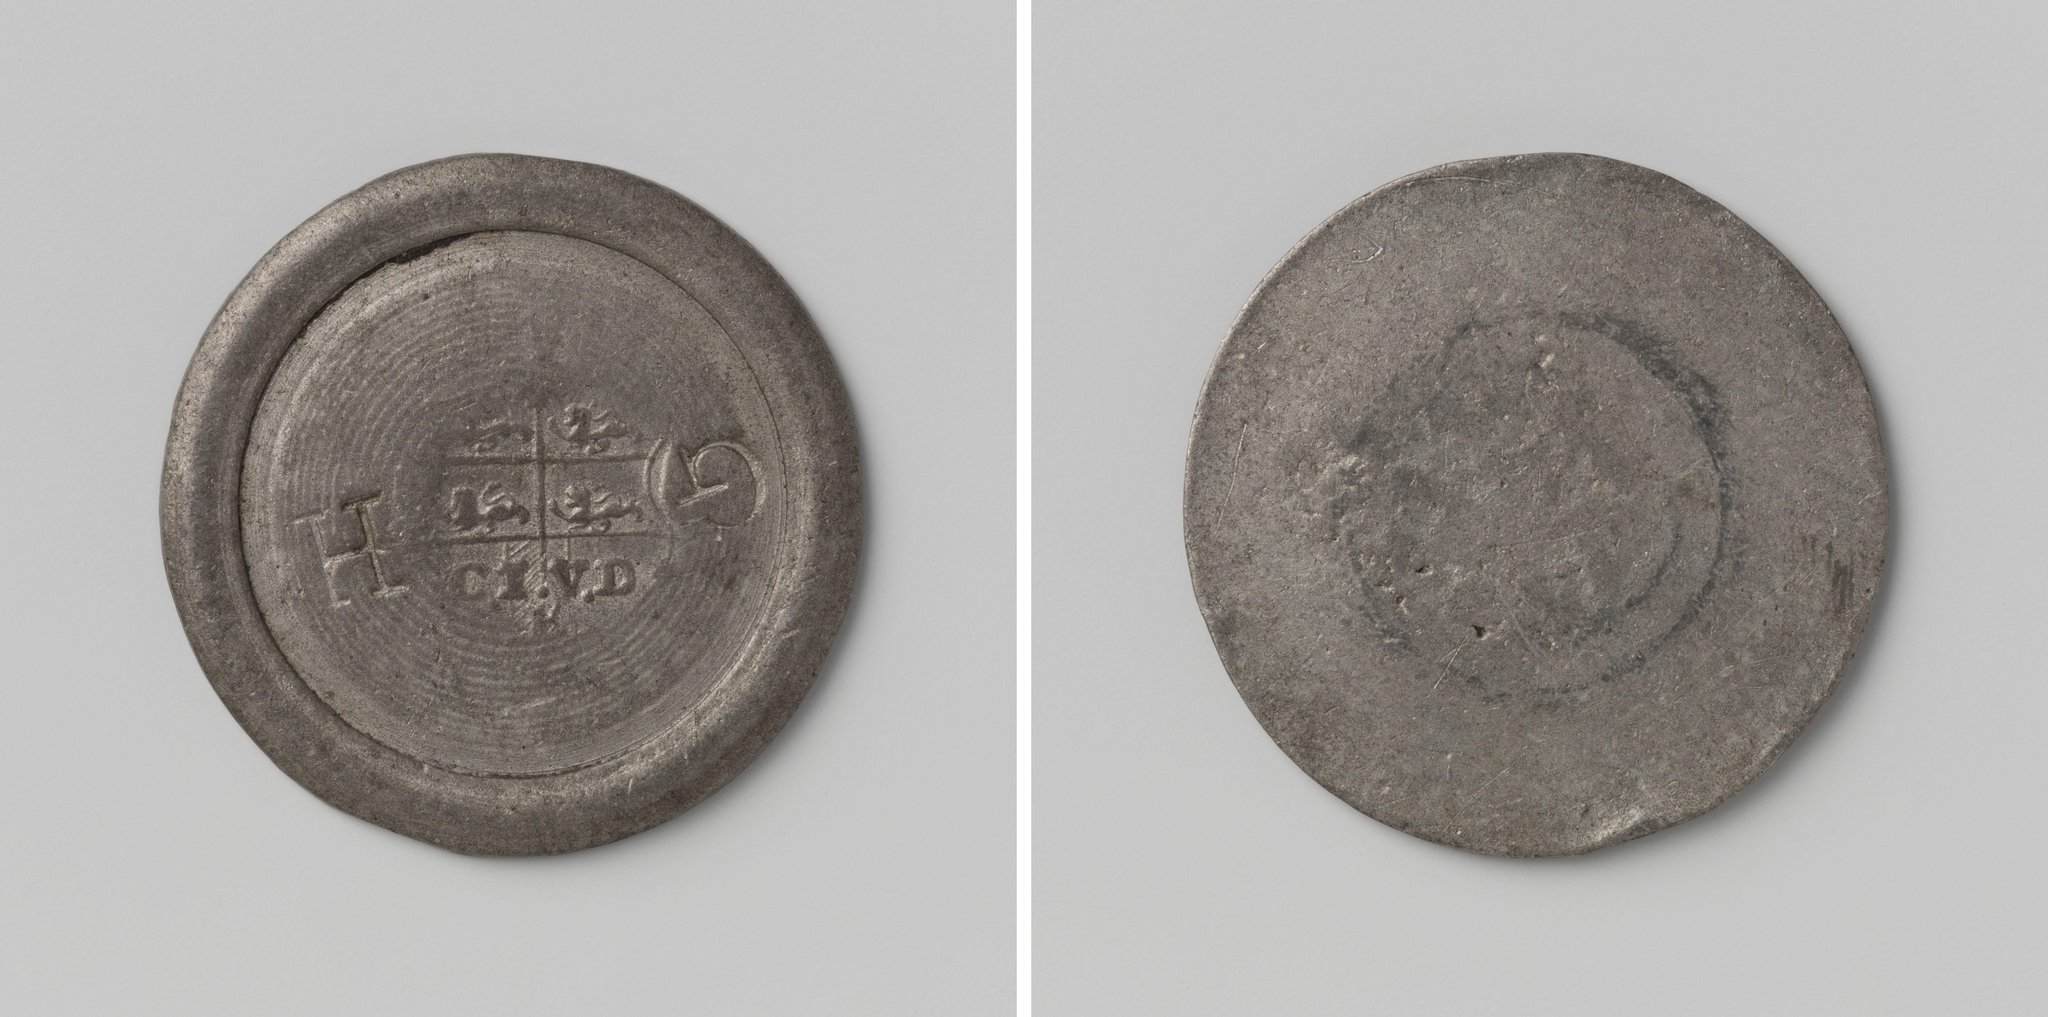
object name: toegangspenning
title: Gasthuis te Rotterdam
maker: Anonymous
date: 1600-1800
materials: lead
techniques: striking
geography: rotterdam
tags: rotterdam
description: Eenzijdige loden penning. Voorzijde: twee stempels: wapenschild boven letters C.I.V.D; tussen letters G en H. Keerzijde: blanco